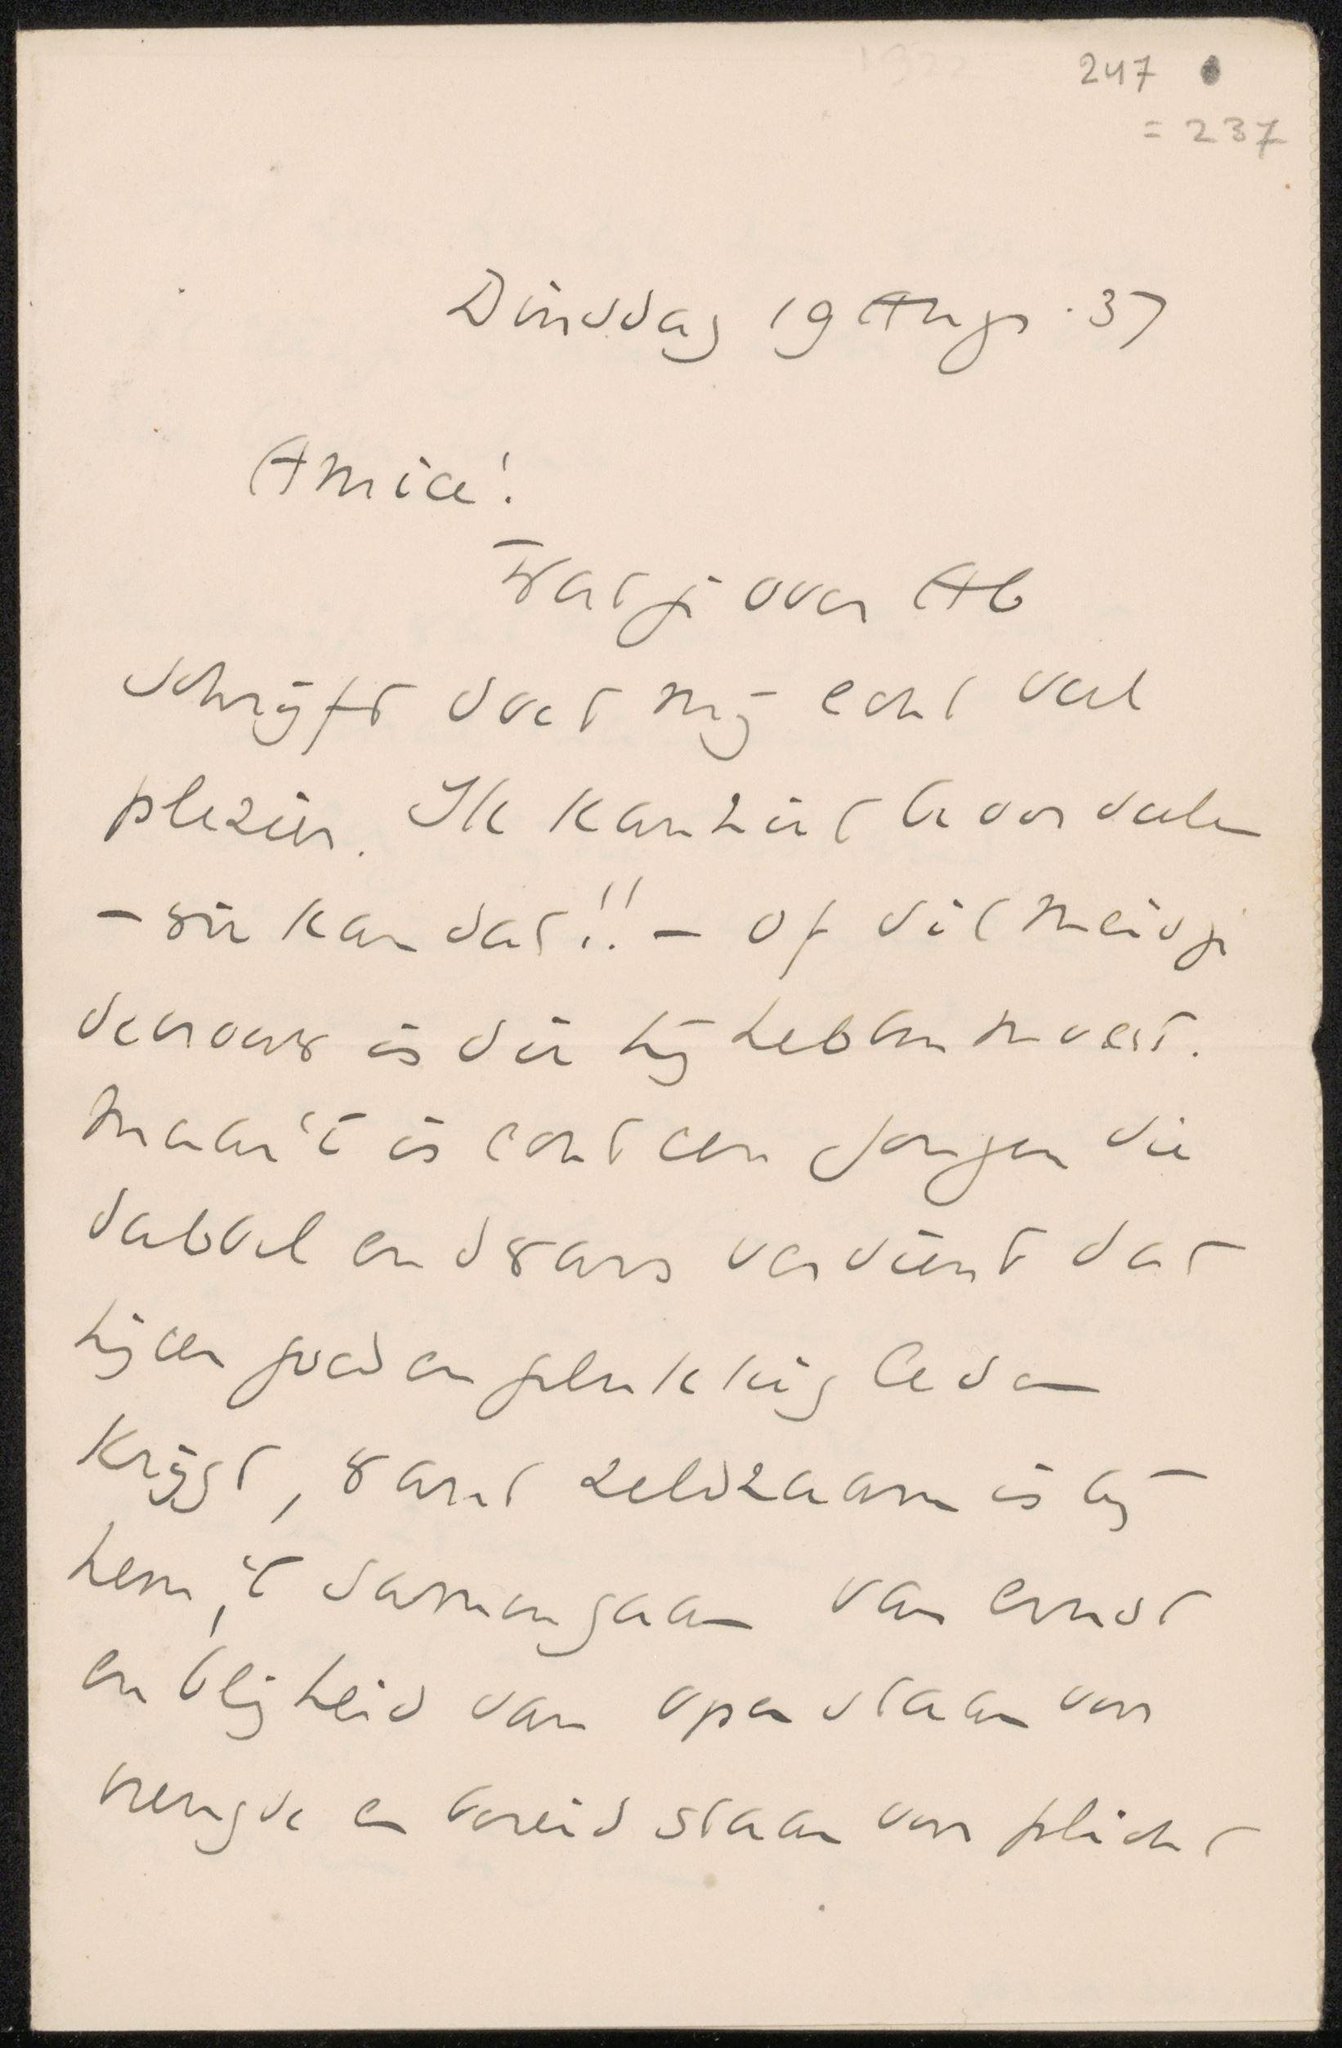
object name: letter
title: Brief aan Willem Bogtman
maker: richard nicolaüs roland holst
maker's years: 1868-1938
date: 1937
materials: ink, paper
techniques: pen, writing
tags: ab bogtman, haarlem, willem bogtman, amsterdam, henriëtte roland holst-van der schalk, passions, emotions, affections, diseases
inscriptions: watermark